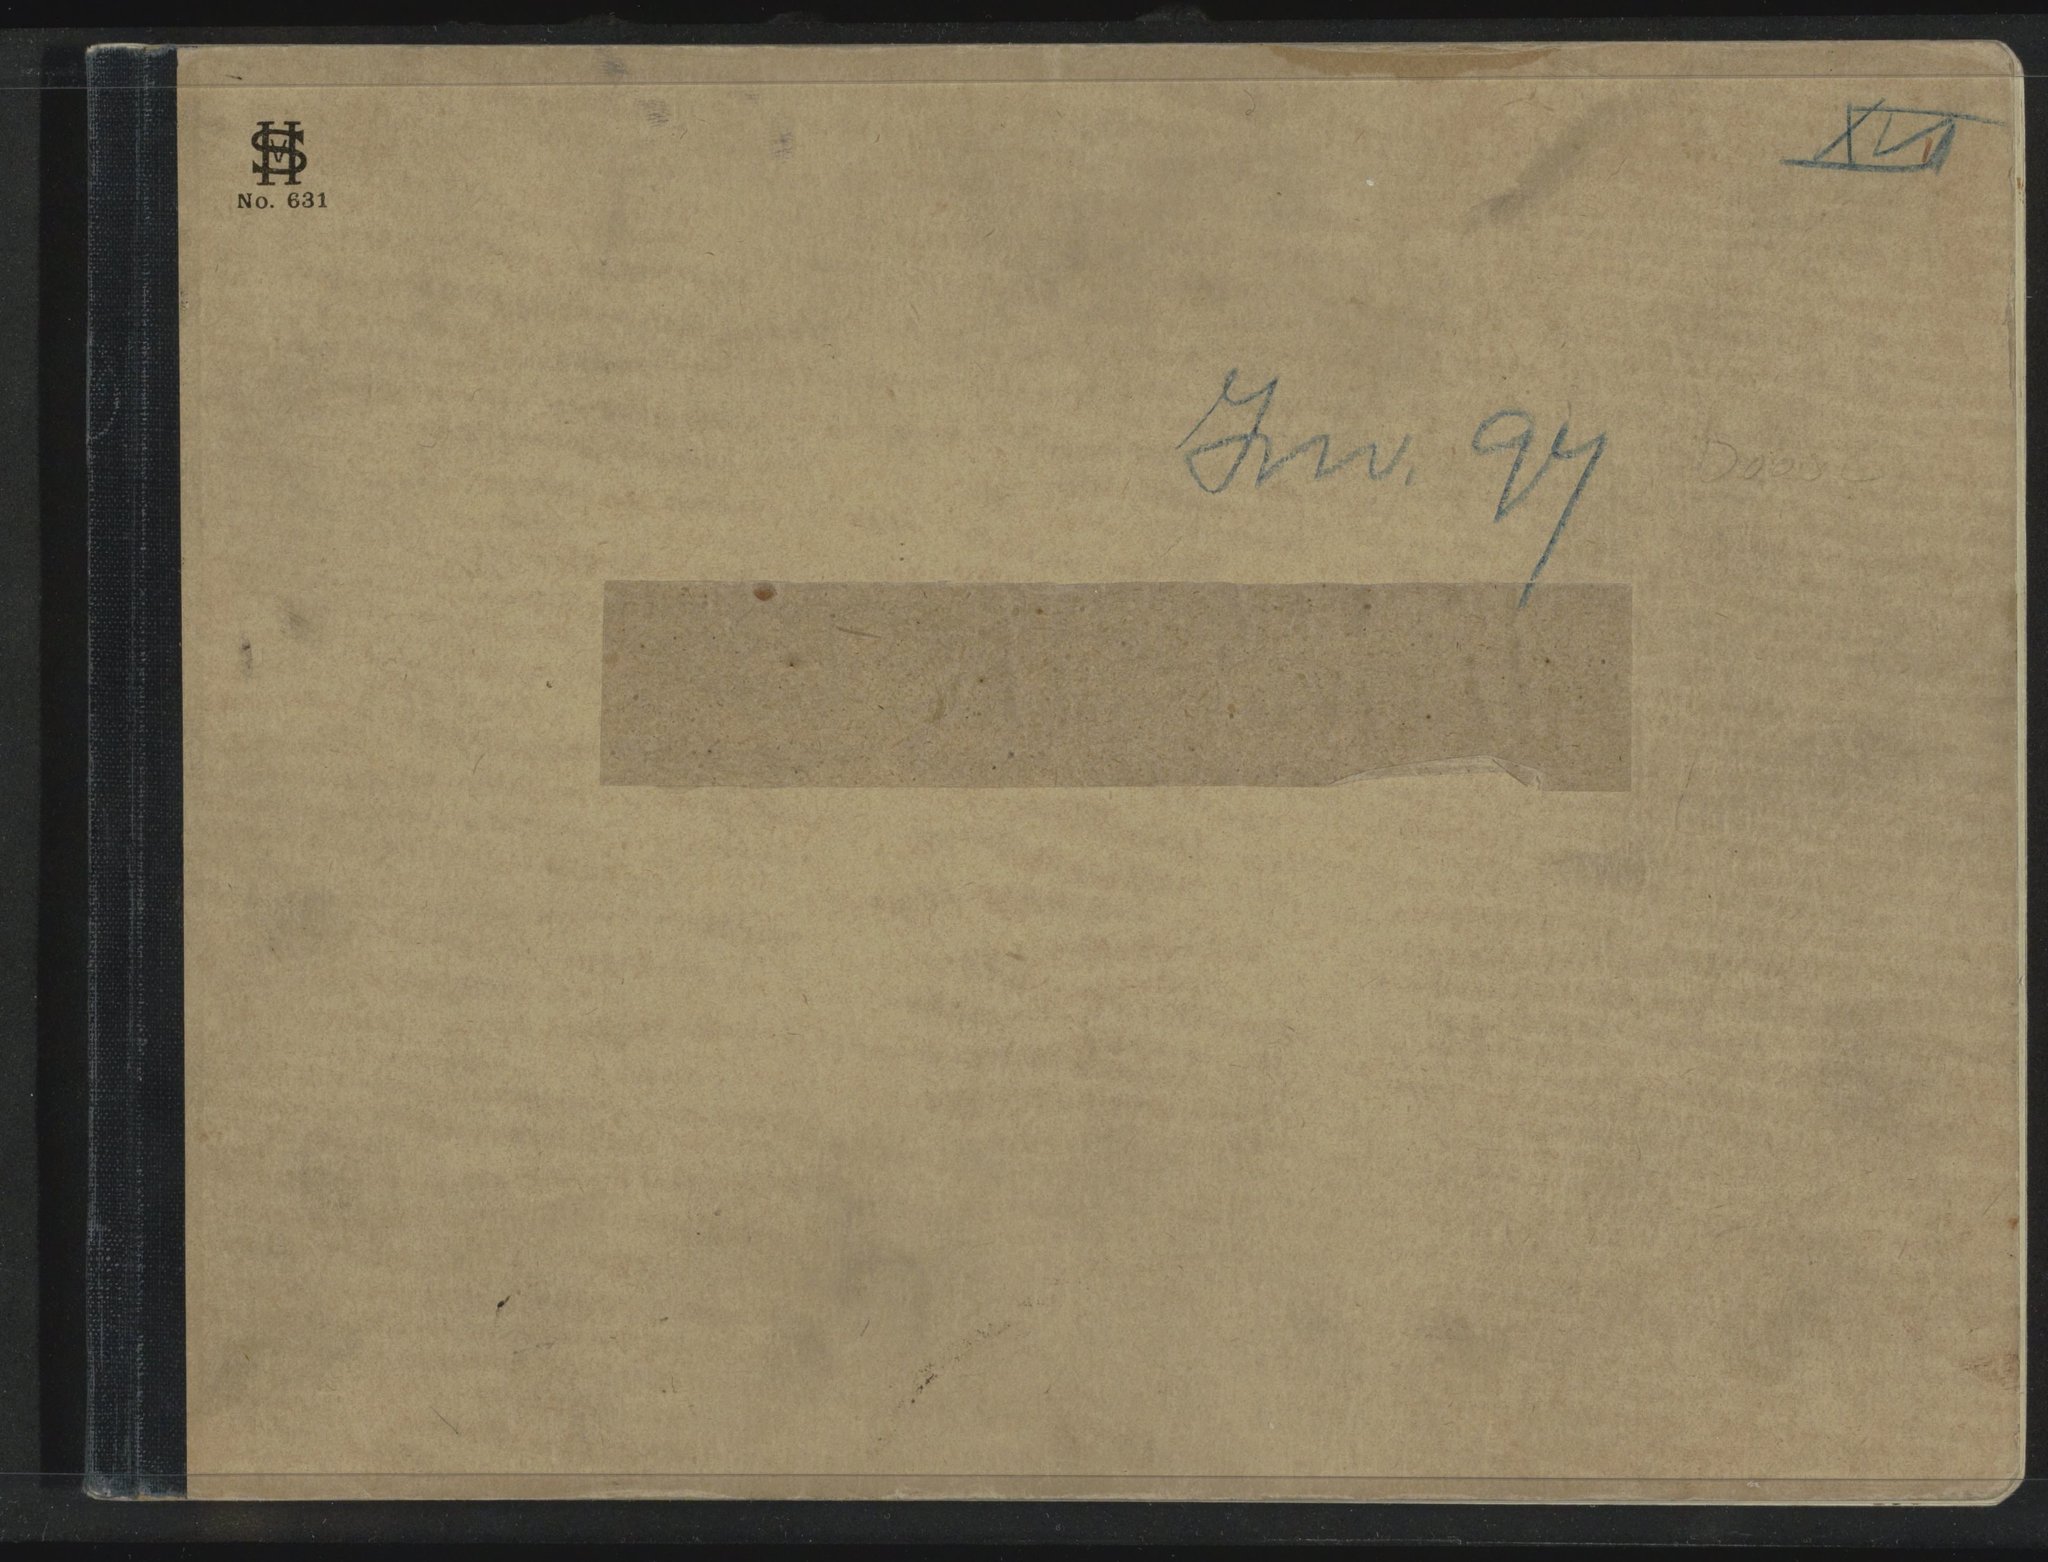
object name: sketchbook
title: Schetsboek XVI met 32 bladen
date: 1915-1934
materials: cardboard, chalk, ink, linen, paper, pencil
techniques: pen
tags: acrobat ~ circus, the audience ~ art performance, vaudeville, variety-show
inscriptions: factory mark: ‘HvS / No. 631’, label: ‘W.M. Stam / Den Haag / 15 Papestraat’, collector's mark: Lugt 2228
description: Israels heeft deze tekeningen vermoedelijk in het voormalige Apollo Theater in Düsseldorf of in Theater Scala te Den Haag vervaardigd. Bladen 6(V), 7(R), 8(V), 9(R), 28(V) en 29(R) zijn blanco en daarom niet beschreven.